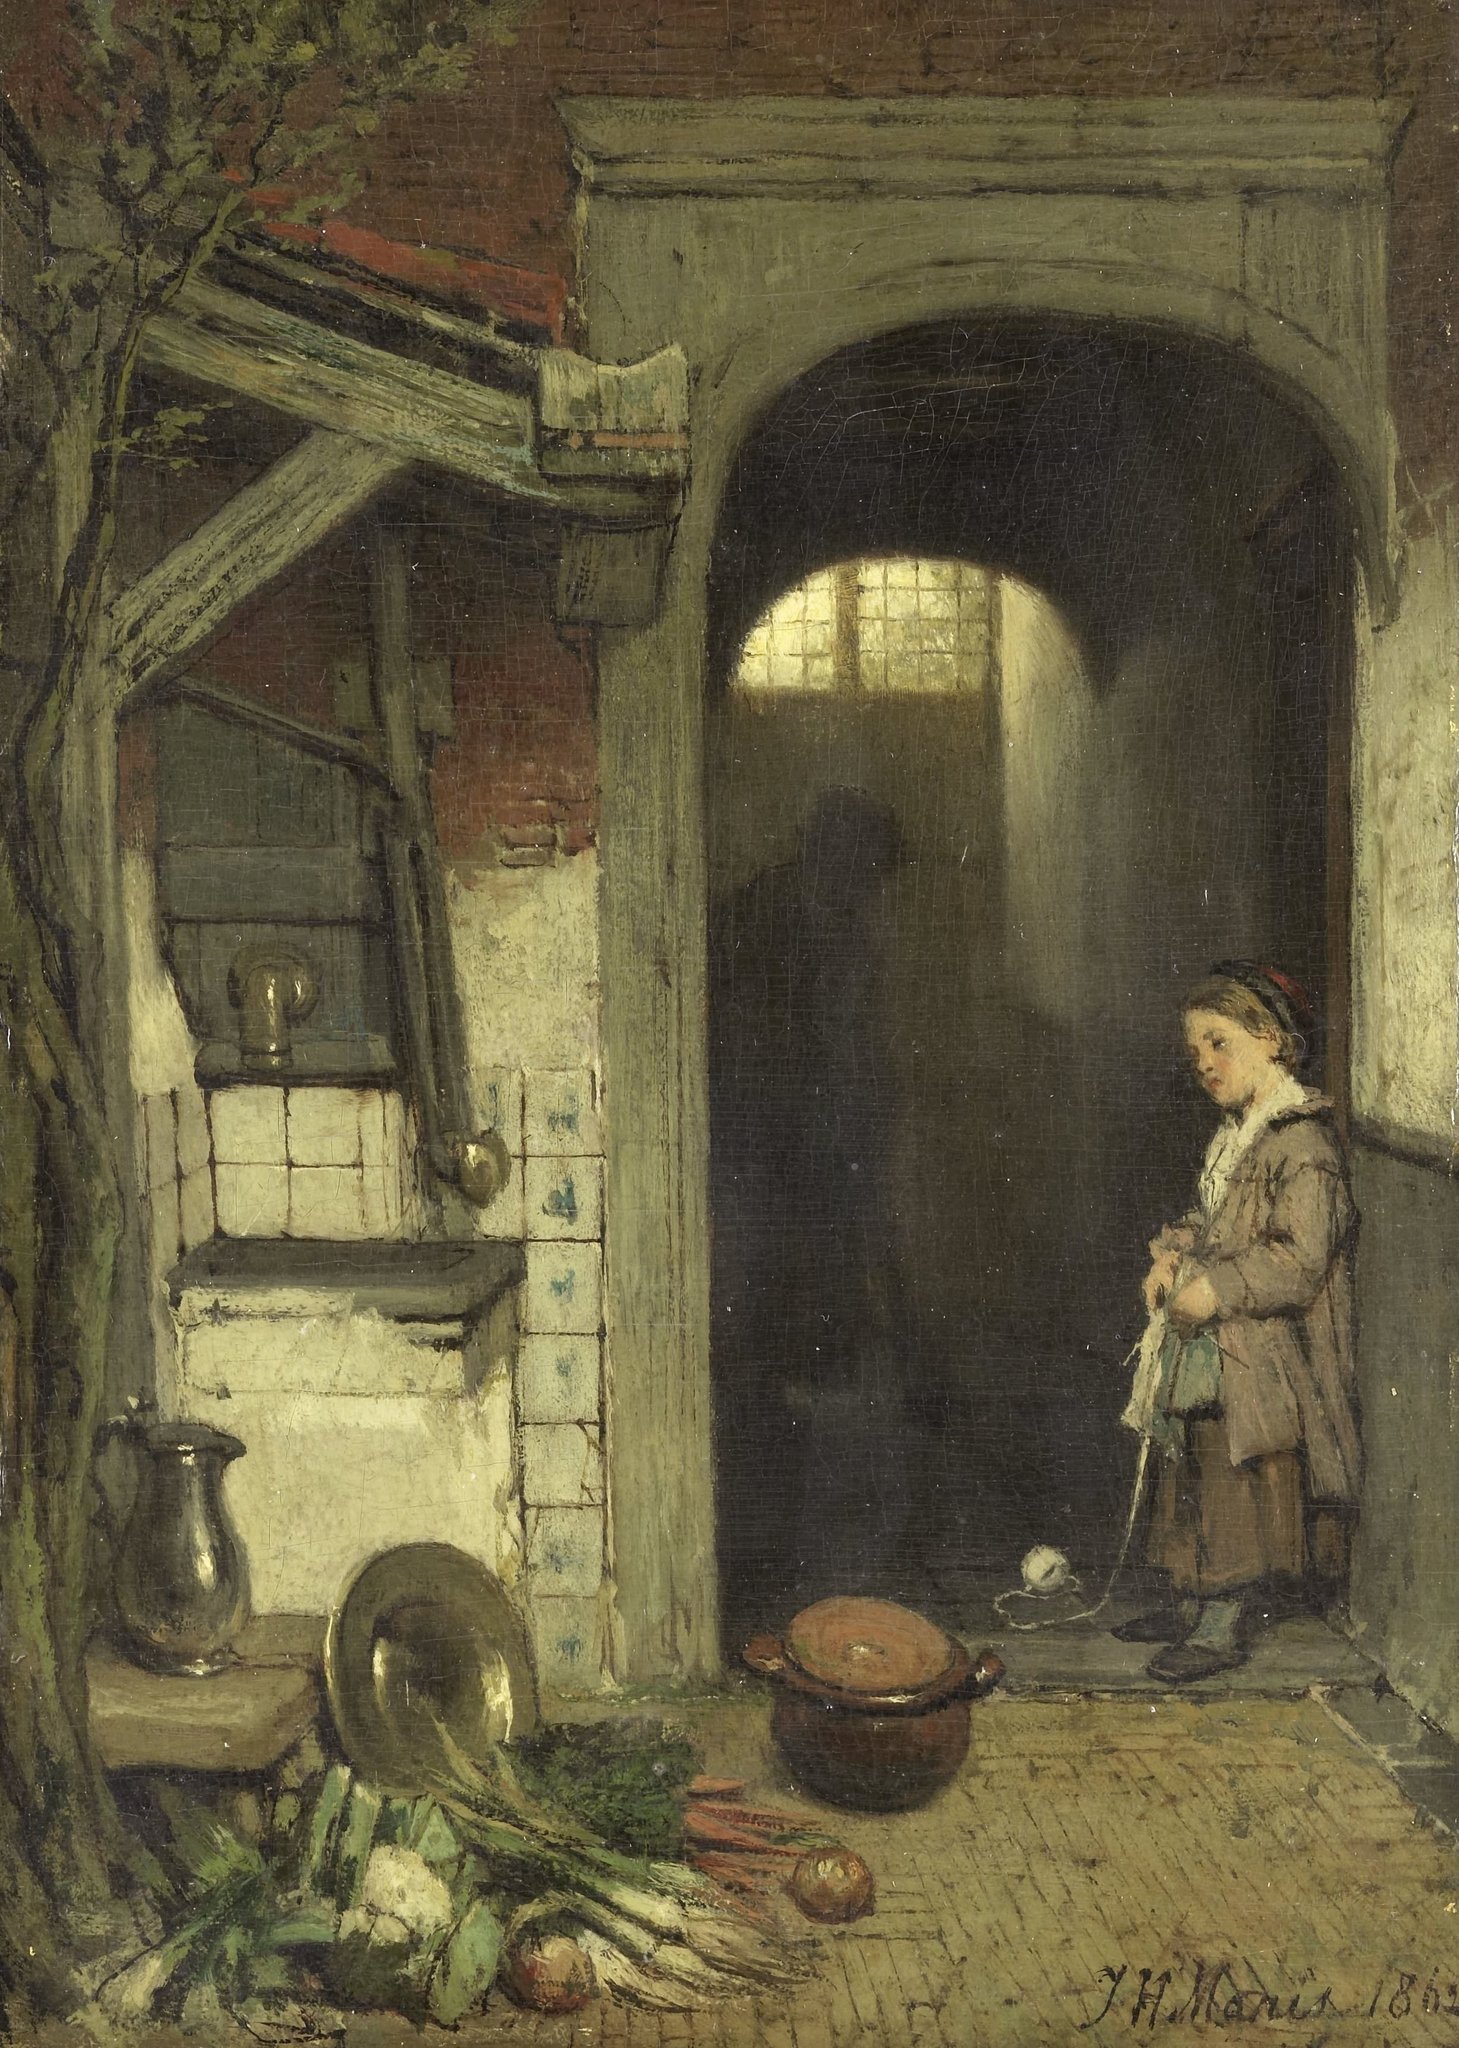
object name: painting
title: Small Courtyard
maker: jacob maris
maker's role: draughtsman, painter, print maker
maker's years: 1837-1899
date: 1862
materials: oil, panel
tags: kitchen, girl (child between toddler and youth)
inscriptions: signature and date: ‘J.H. Maris 1862’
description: Achterplaatsje. Een meisje staat in de deuropening aan de achterkant van een huis. Links een tinnen kan en bord bij een stapel groente voor een waterpomp onder een afdakje.